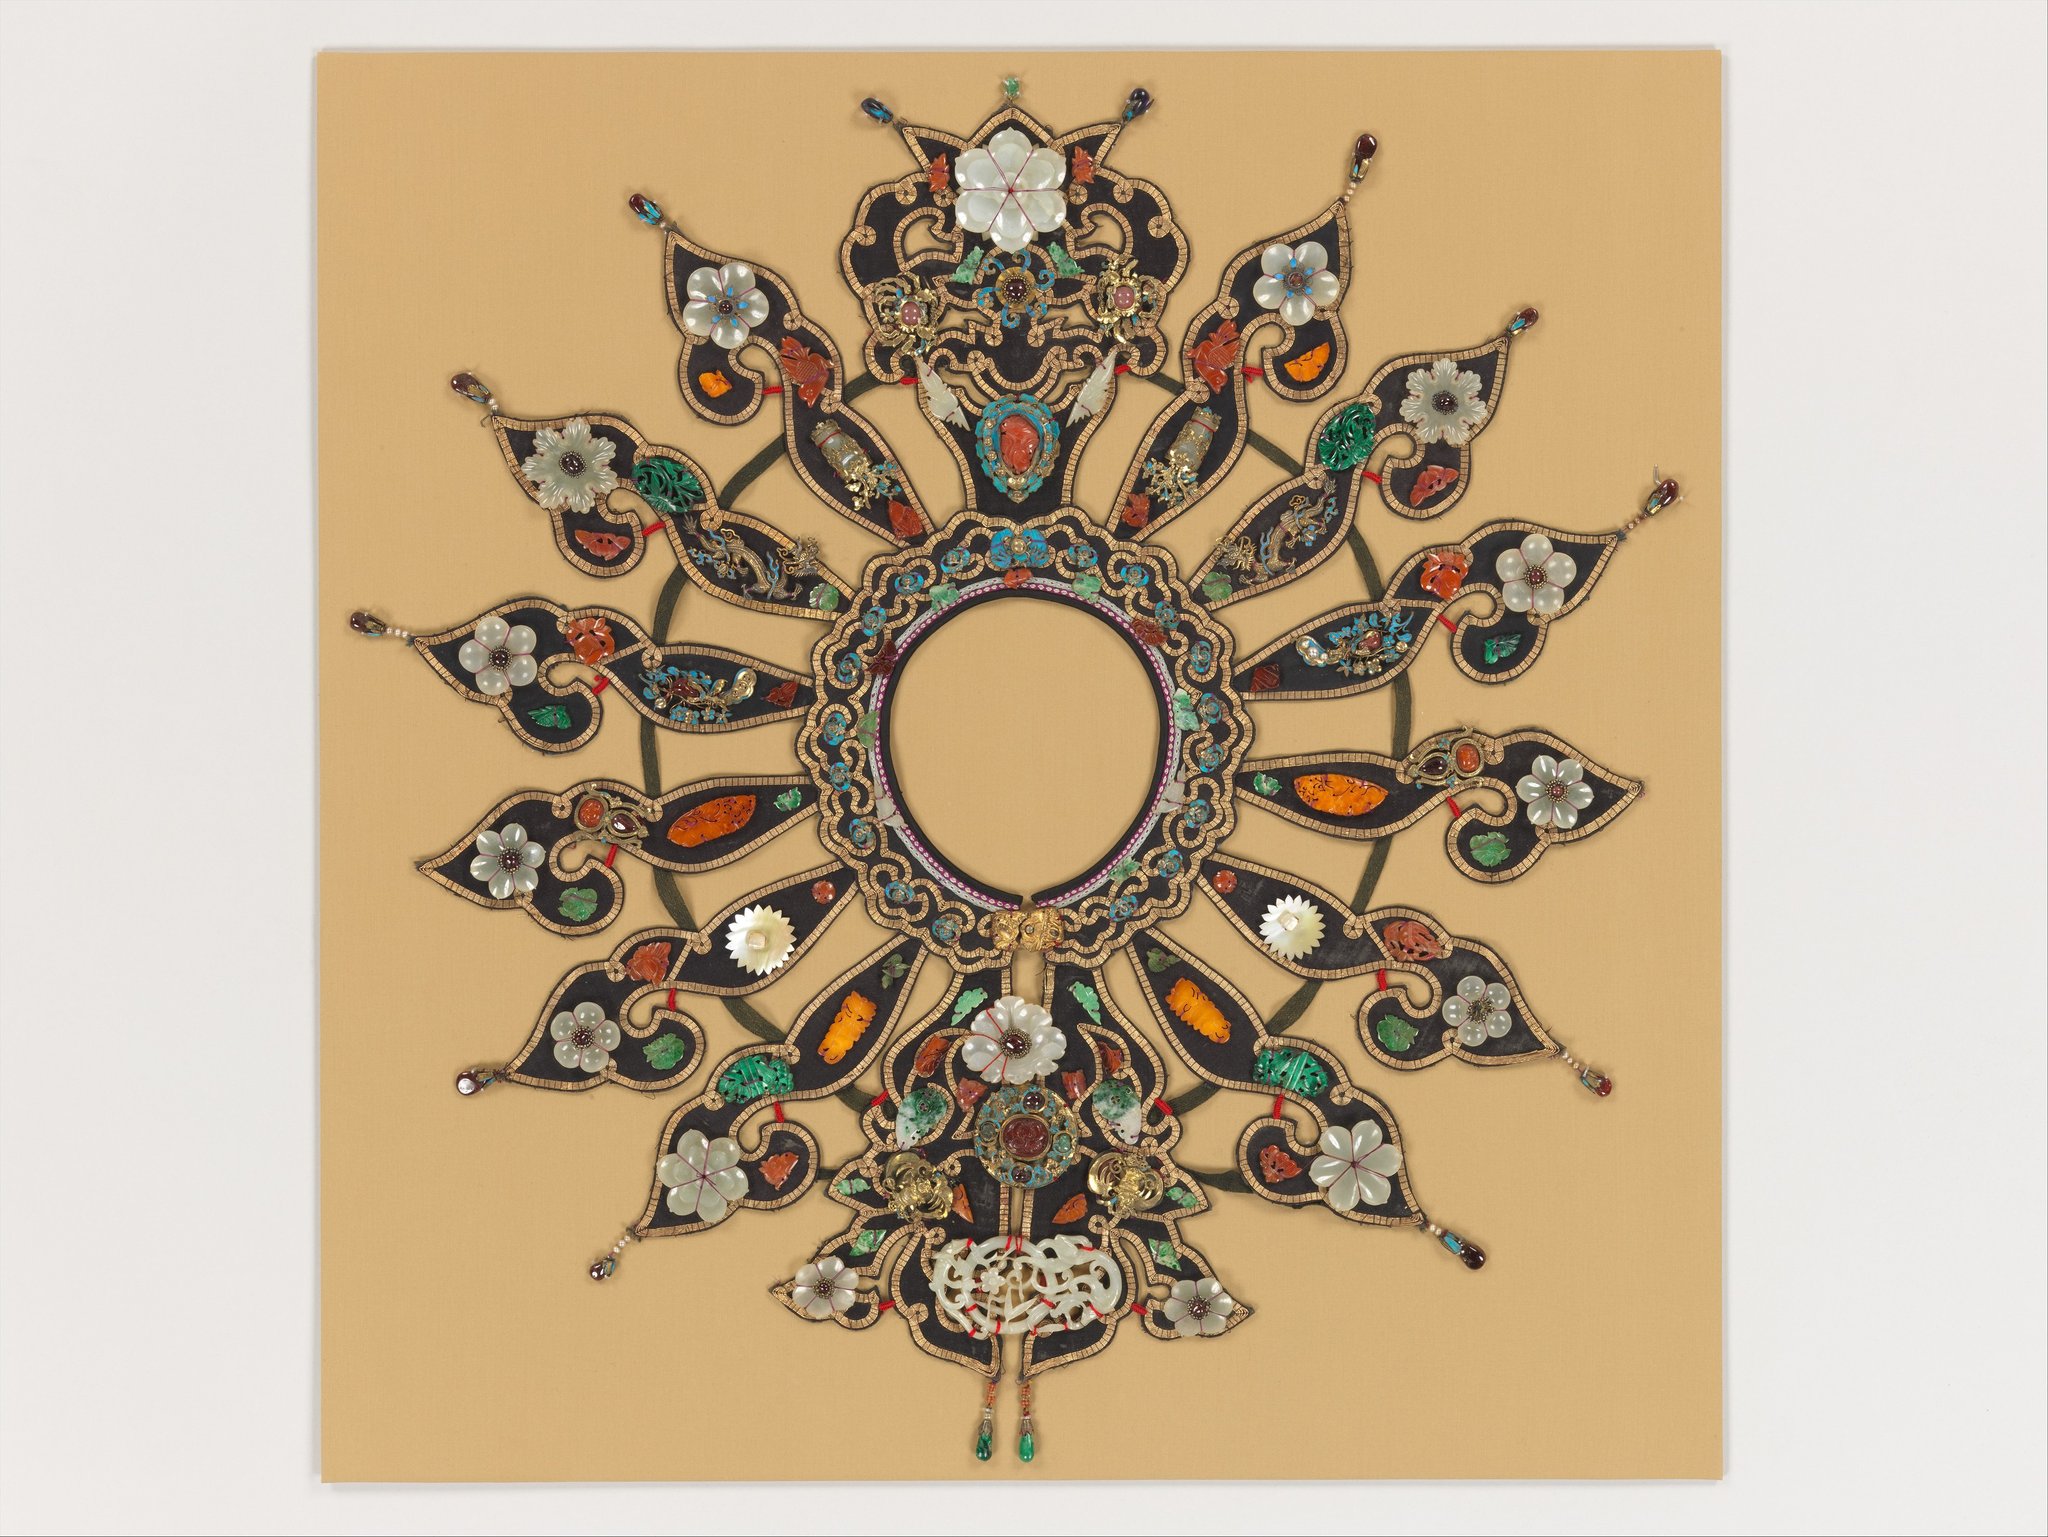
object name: collar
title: Theatrical Collar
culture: chinese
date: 1701-1800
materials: amber, feather, gilt, glass, jade, metal, metal thread, mother of pearl, pearl, silk, stone